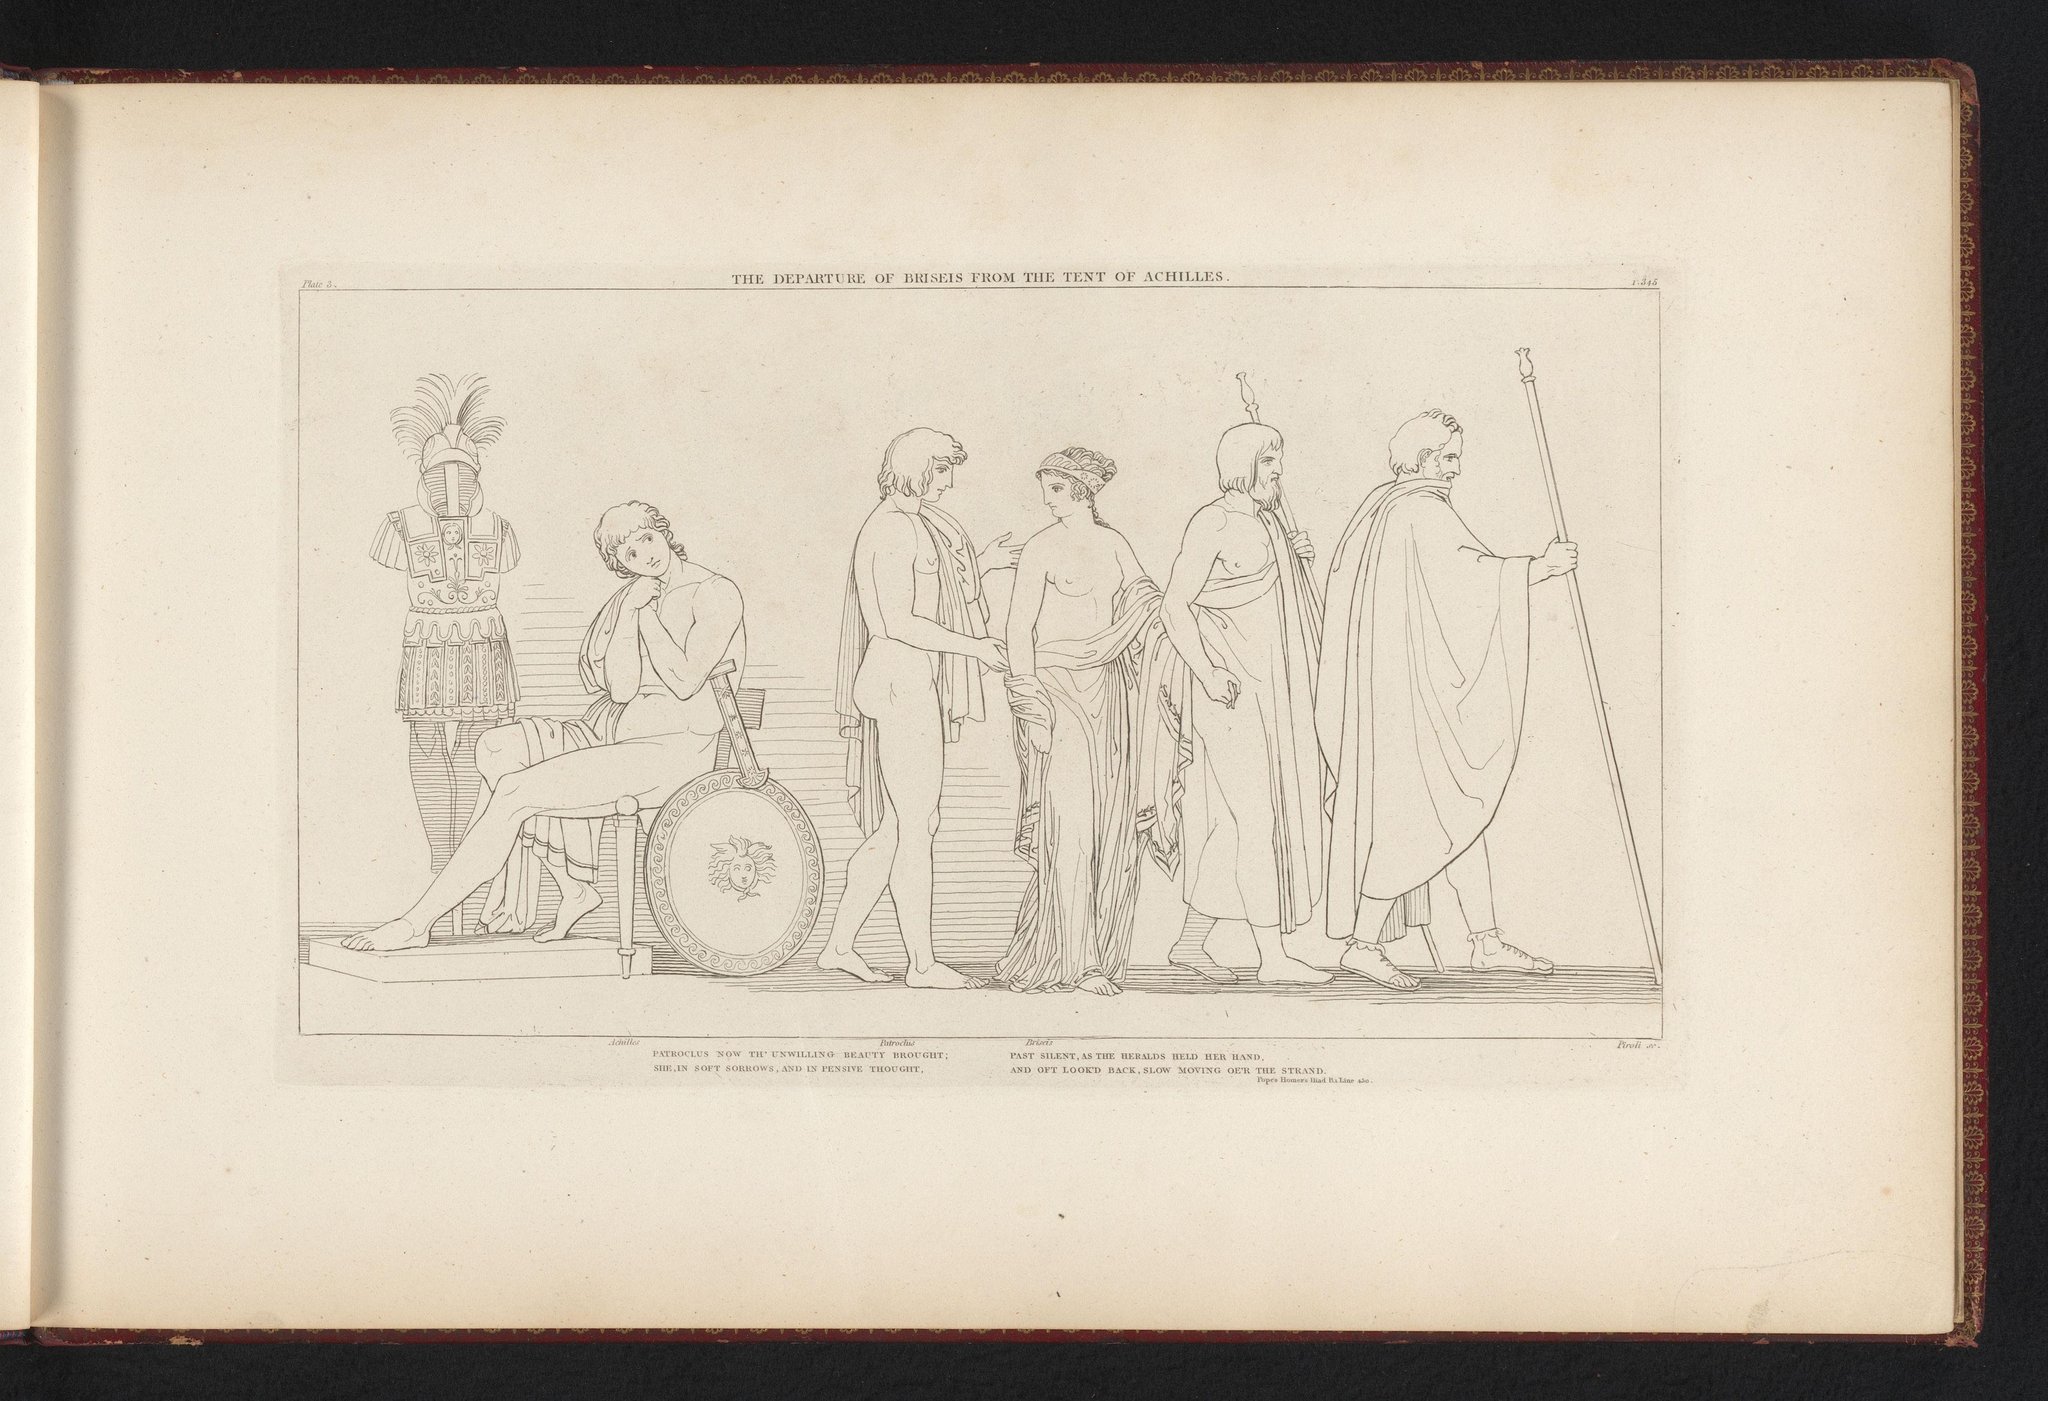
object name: print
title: Iliad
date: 1805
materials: paper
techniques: etching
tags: briseis is taken away from achilles and led to agamemnon by the heralds talthybius and eurybates; achilles may be holding a lyre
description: Prent maakt onderdeel uit van een serie met 39 prenten over de Ilias, geschreven door Homerus.